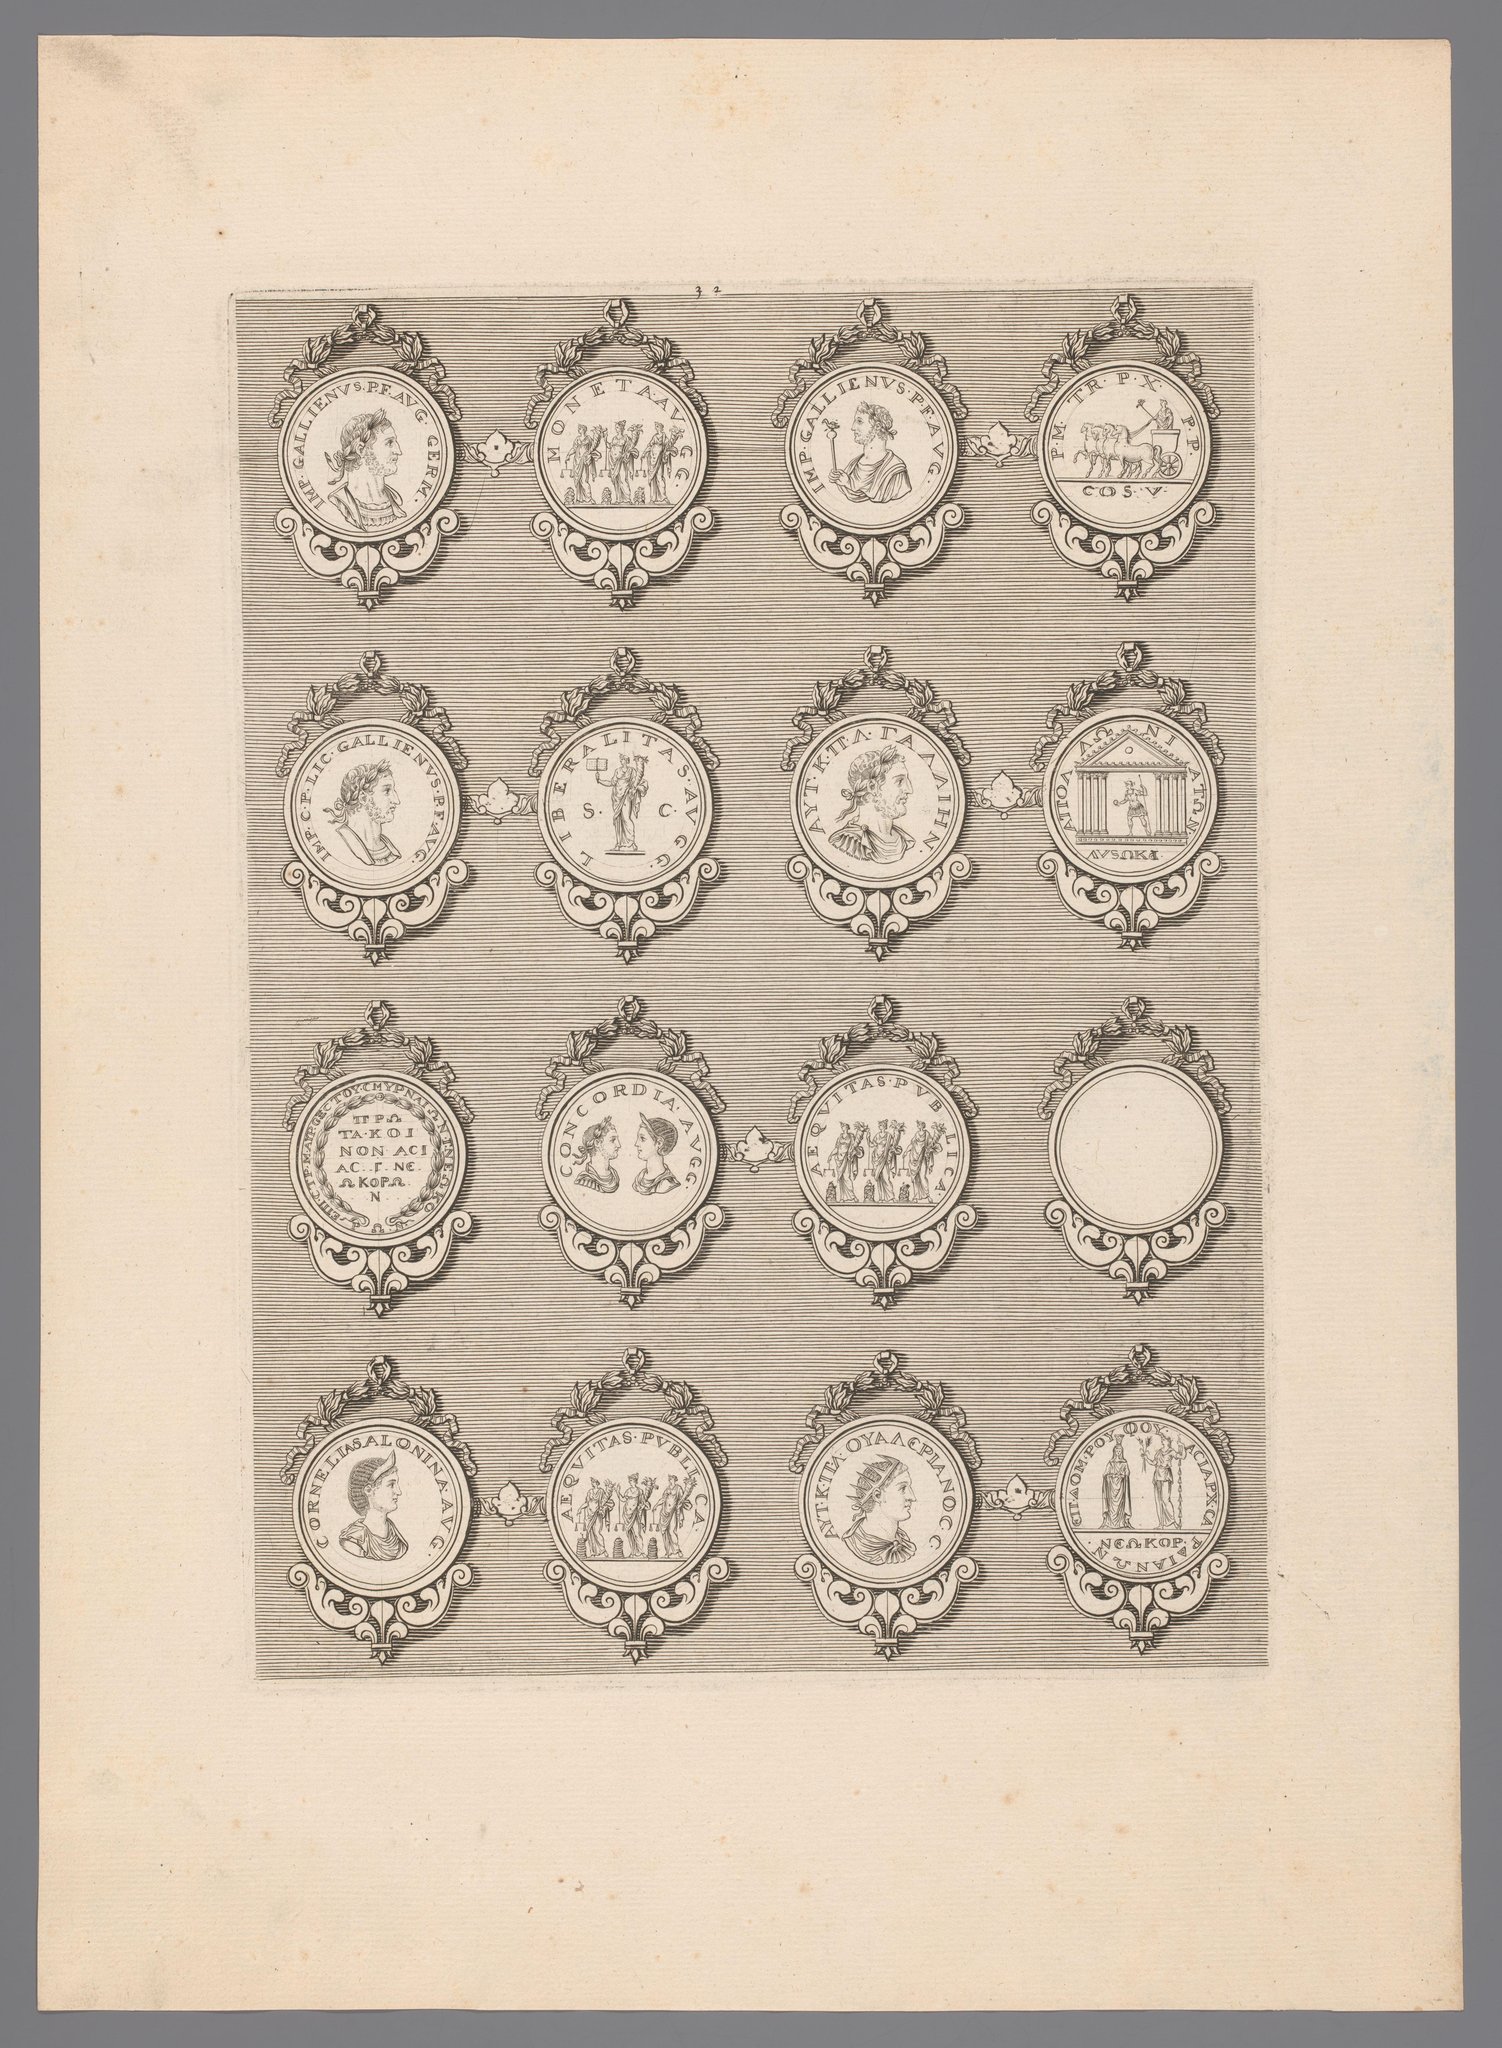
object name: print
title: Zestien penningen met versierde lijsten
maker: simon de la boissière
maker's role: print maker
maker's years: 1637-1682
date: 1647-1682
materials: paper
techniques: etching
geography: france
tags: medal (considered as a piece of sculpture, regardless of its specific function)